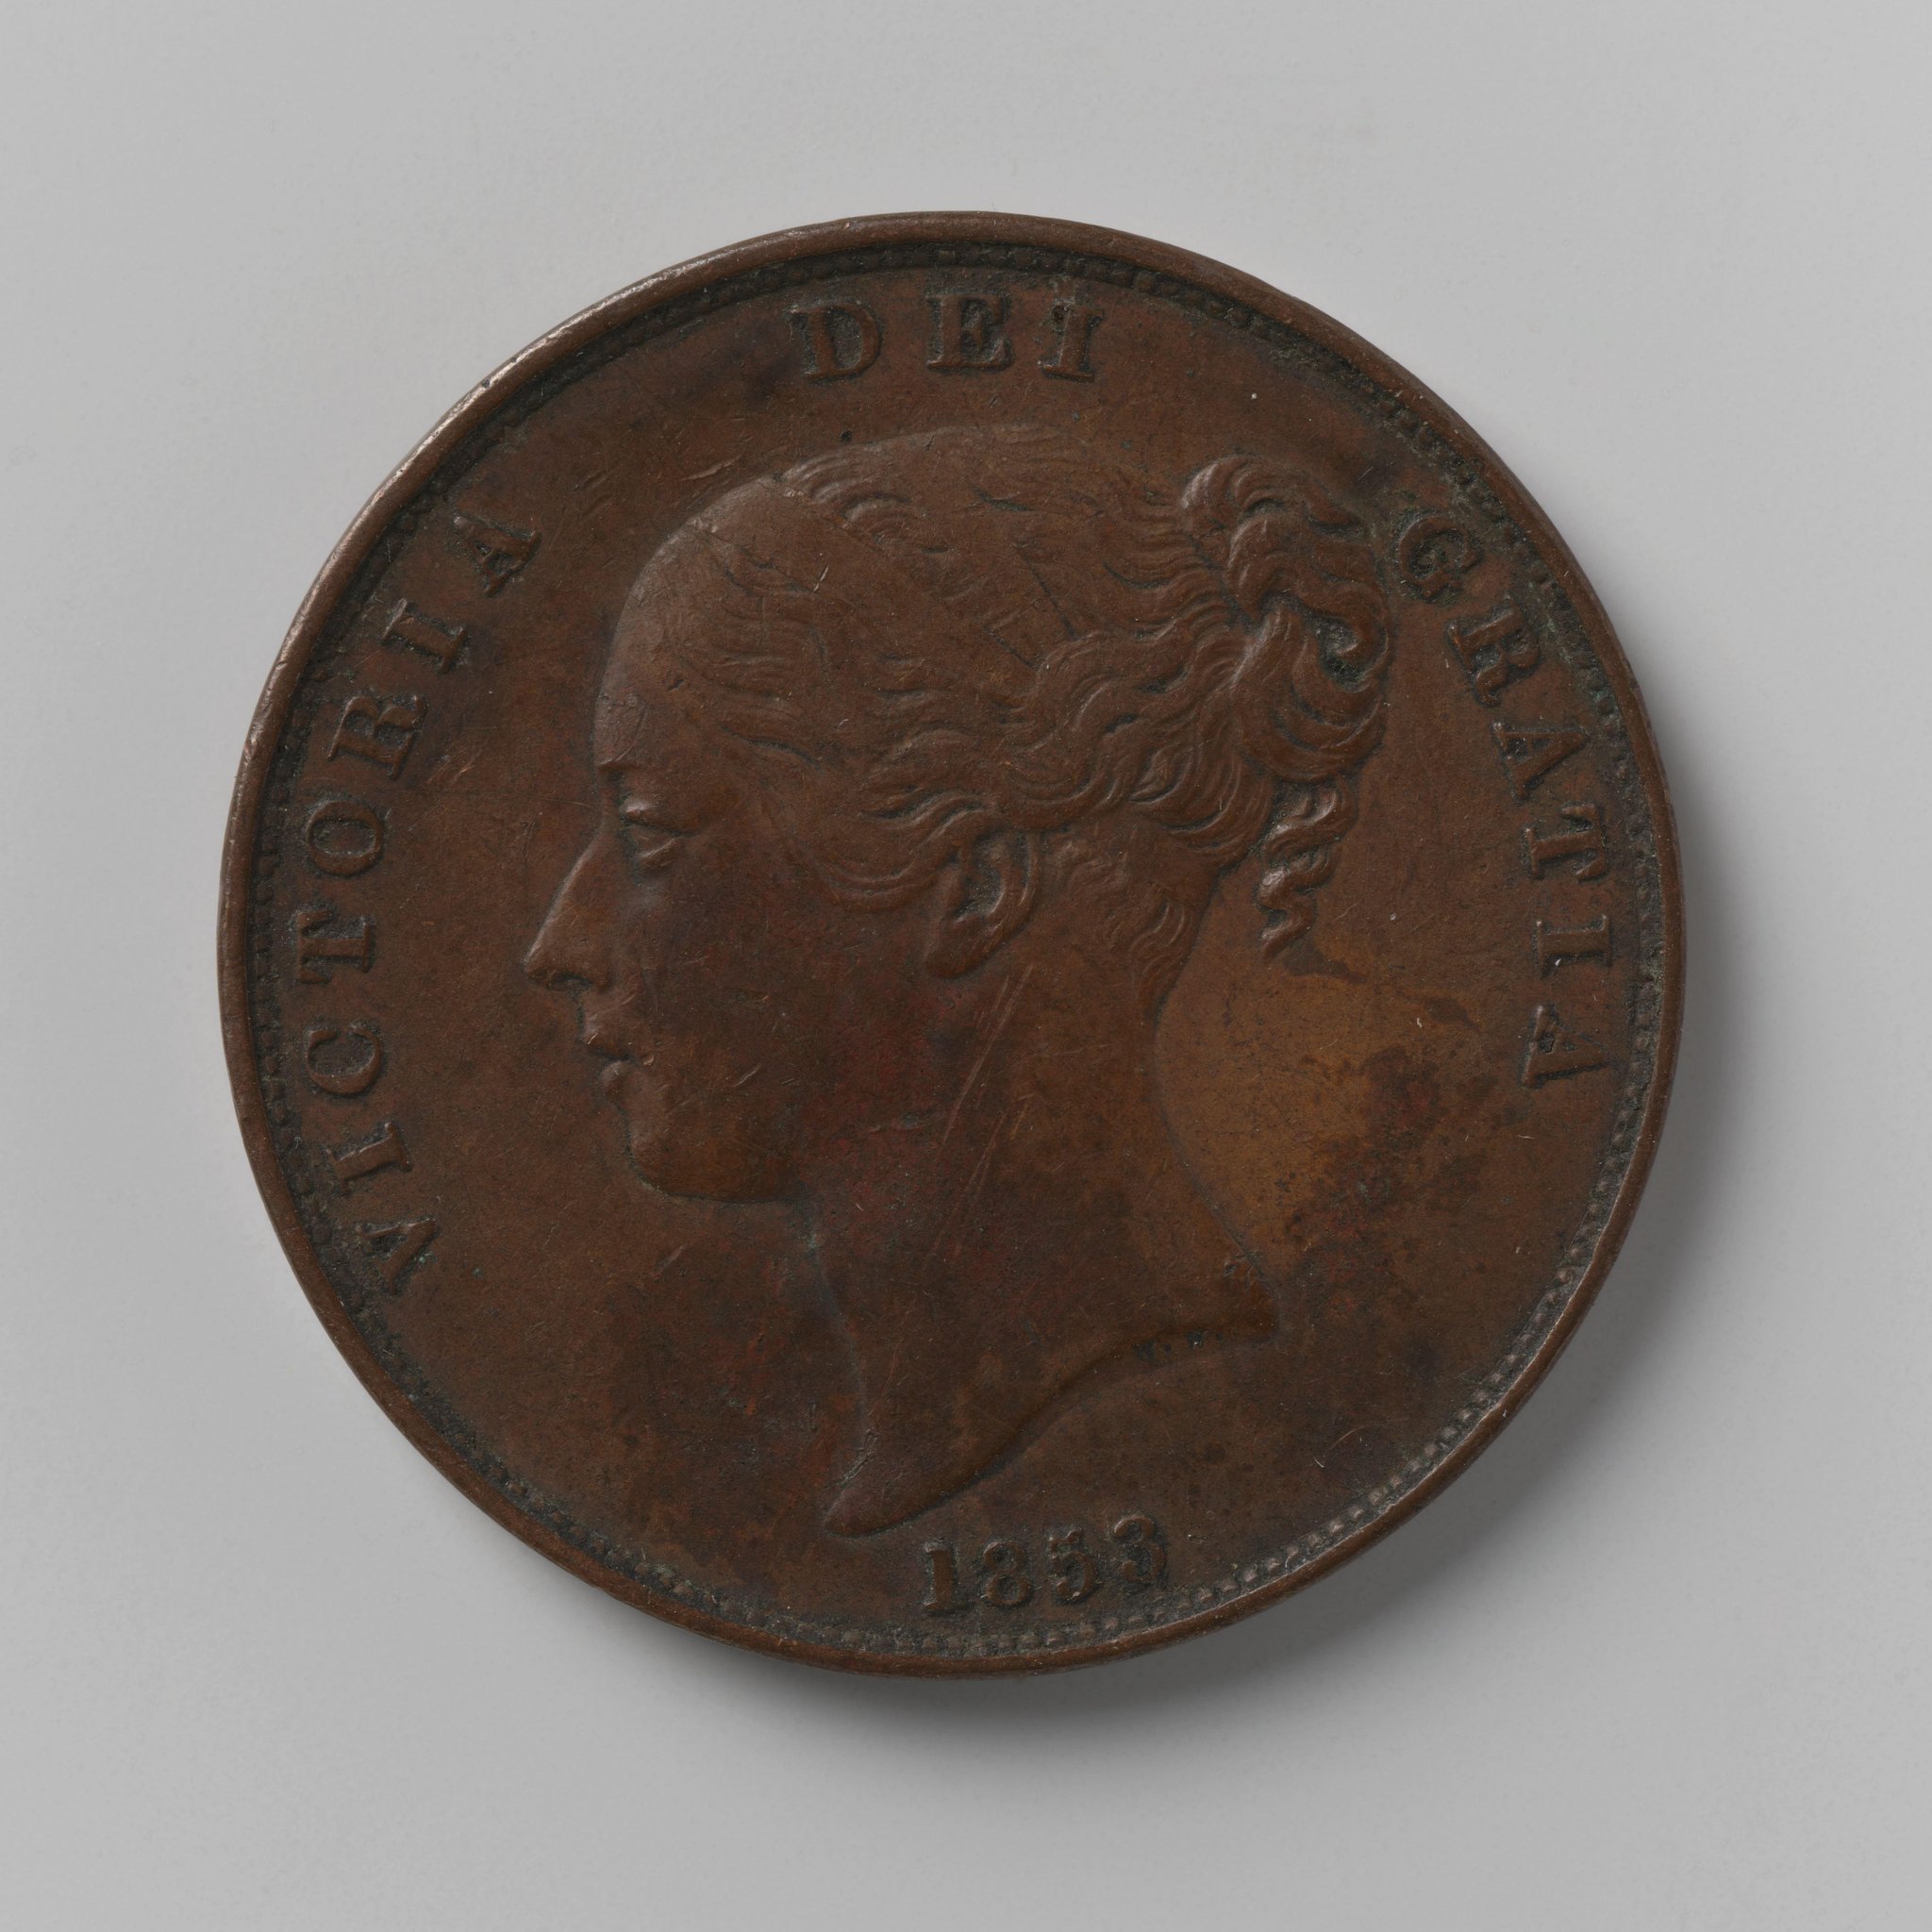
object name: coin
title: Engeland, Victoria, penny, 1853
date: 1853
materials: copper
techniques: striking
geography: london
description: Koperen munt. Voorzijde: hoofd van de koningin naar links [young head]. Jaartal onderaan. Keerzijde: tegen wapenschild gezeten Brittannia met drietand naar rechts. In afsnede klaverblad, roos en distel. Gladde rand.